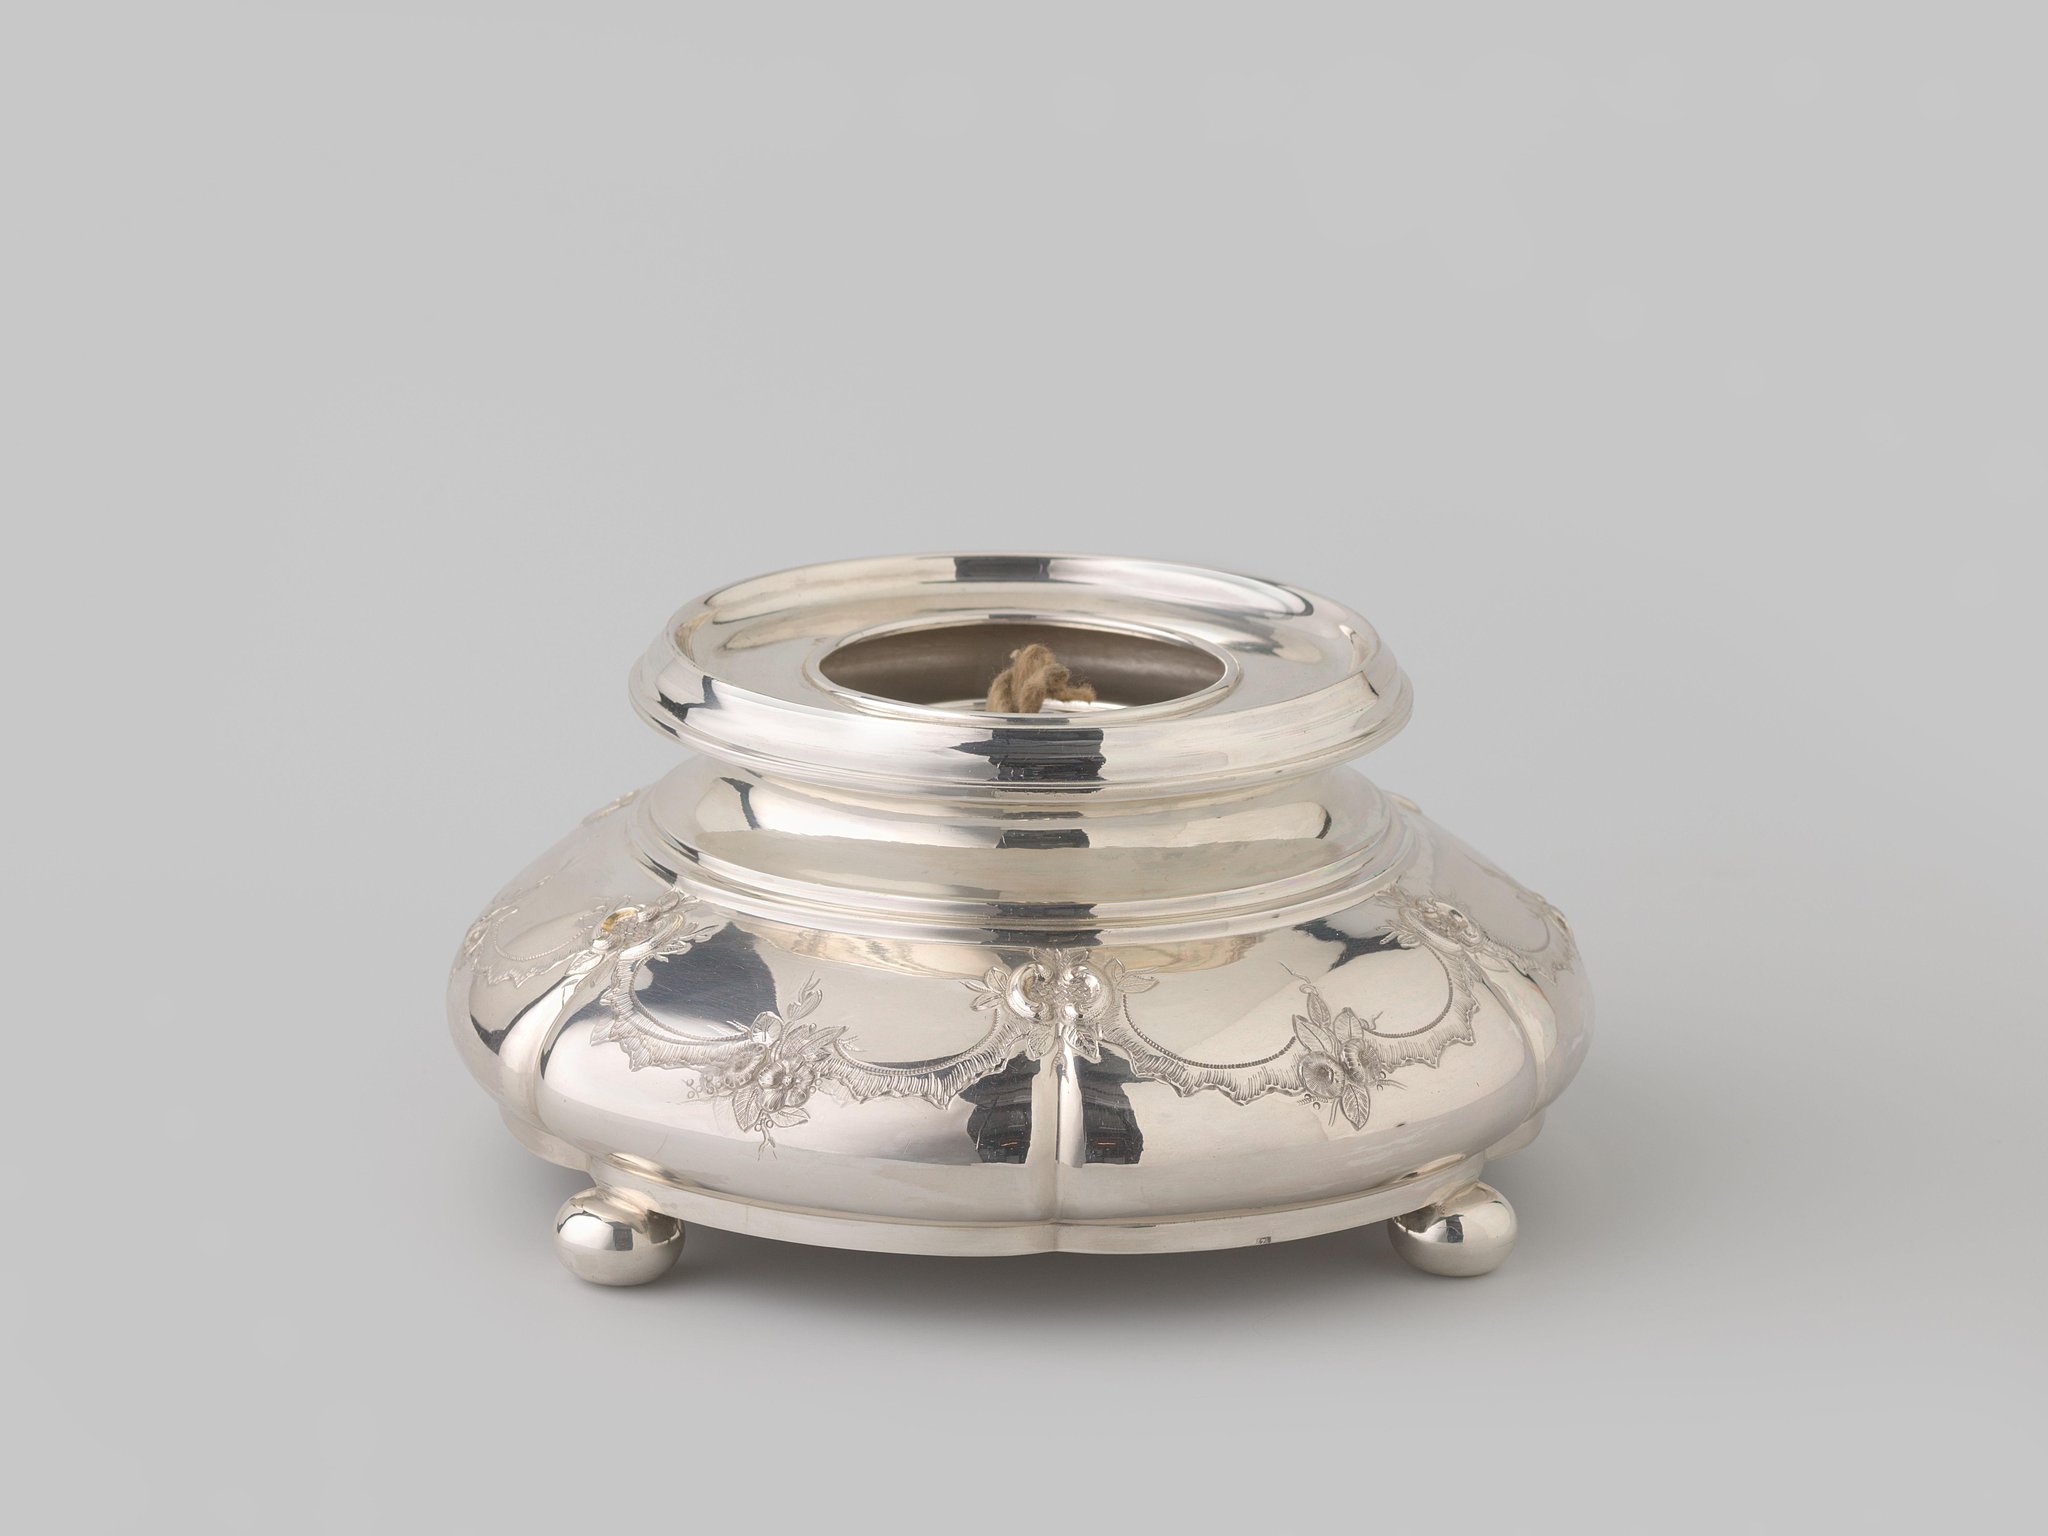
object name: komfoor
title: Zilveren komfoor uit een koffie- en theeservies van elf delen dat toebehoorde aan J.D. Preuijt (1801-1887), aan hem gegeven bij zijn jubileum in 1873.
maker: pieter zöllner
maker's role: silversmith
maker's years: 1806-1894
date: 1873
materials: gold, silver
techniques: engraving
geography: rotterdam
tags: mayor, geervliet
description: Zilveren rond komfoor met geschulpte en gegraveerde ornamenten met bloemenmotieven. Met brandstofreservoir met lont. Staat op vier pootjes.